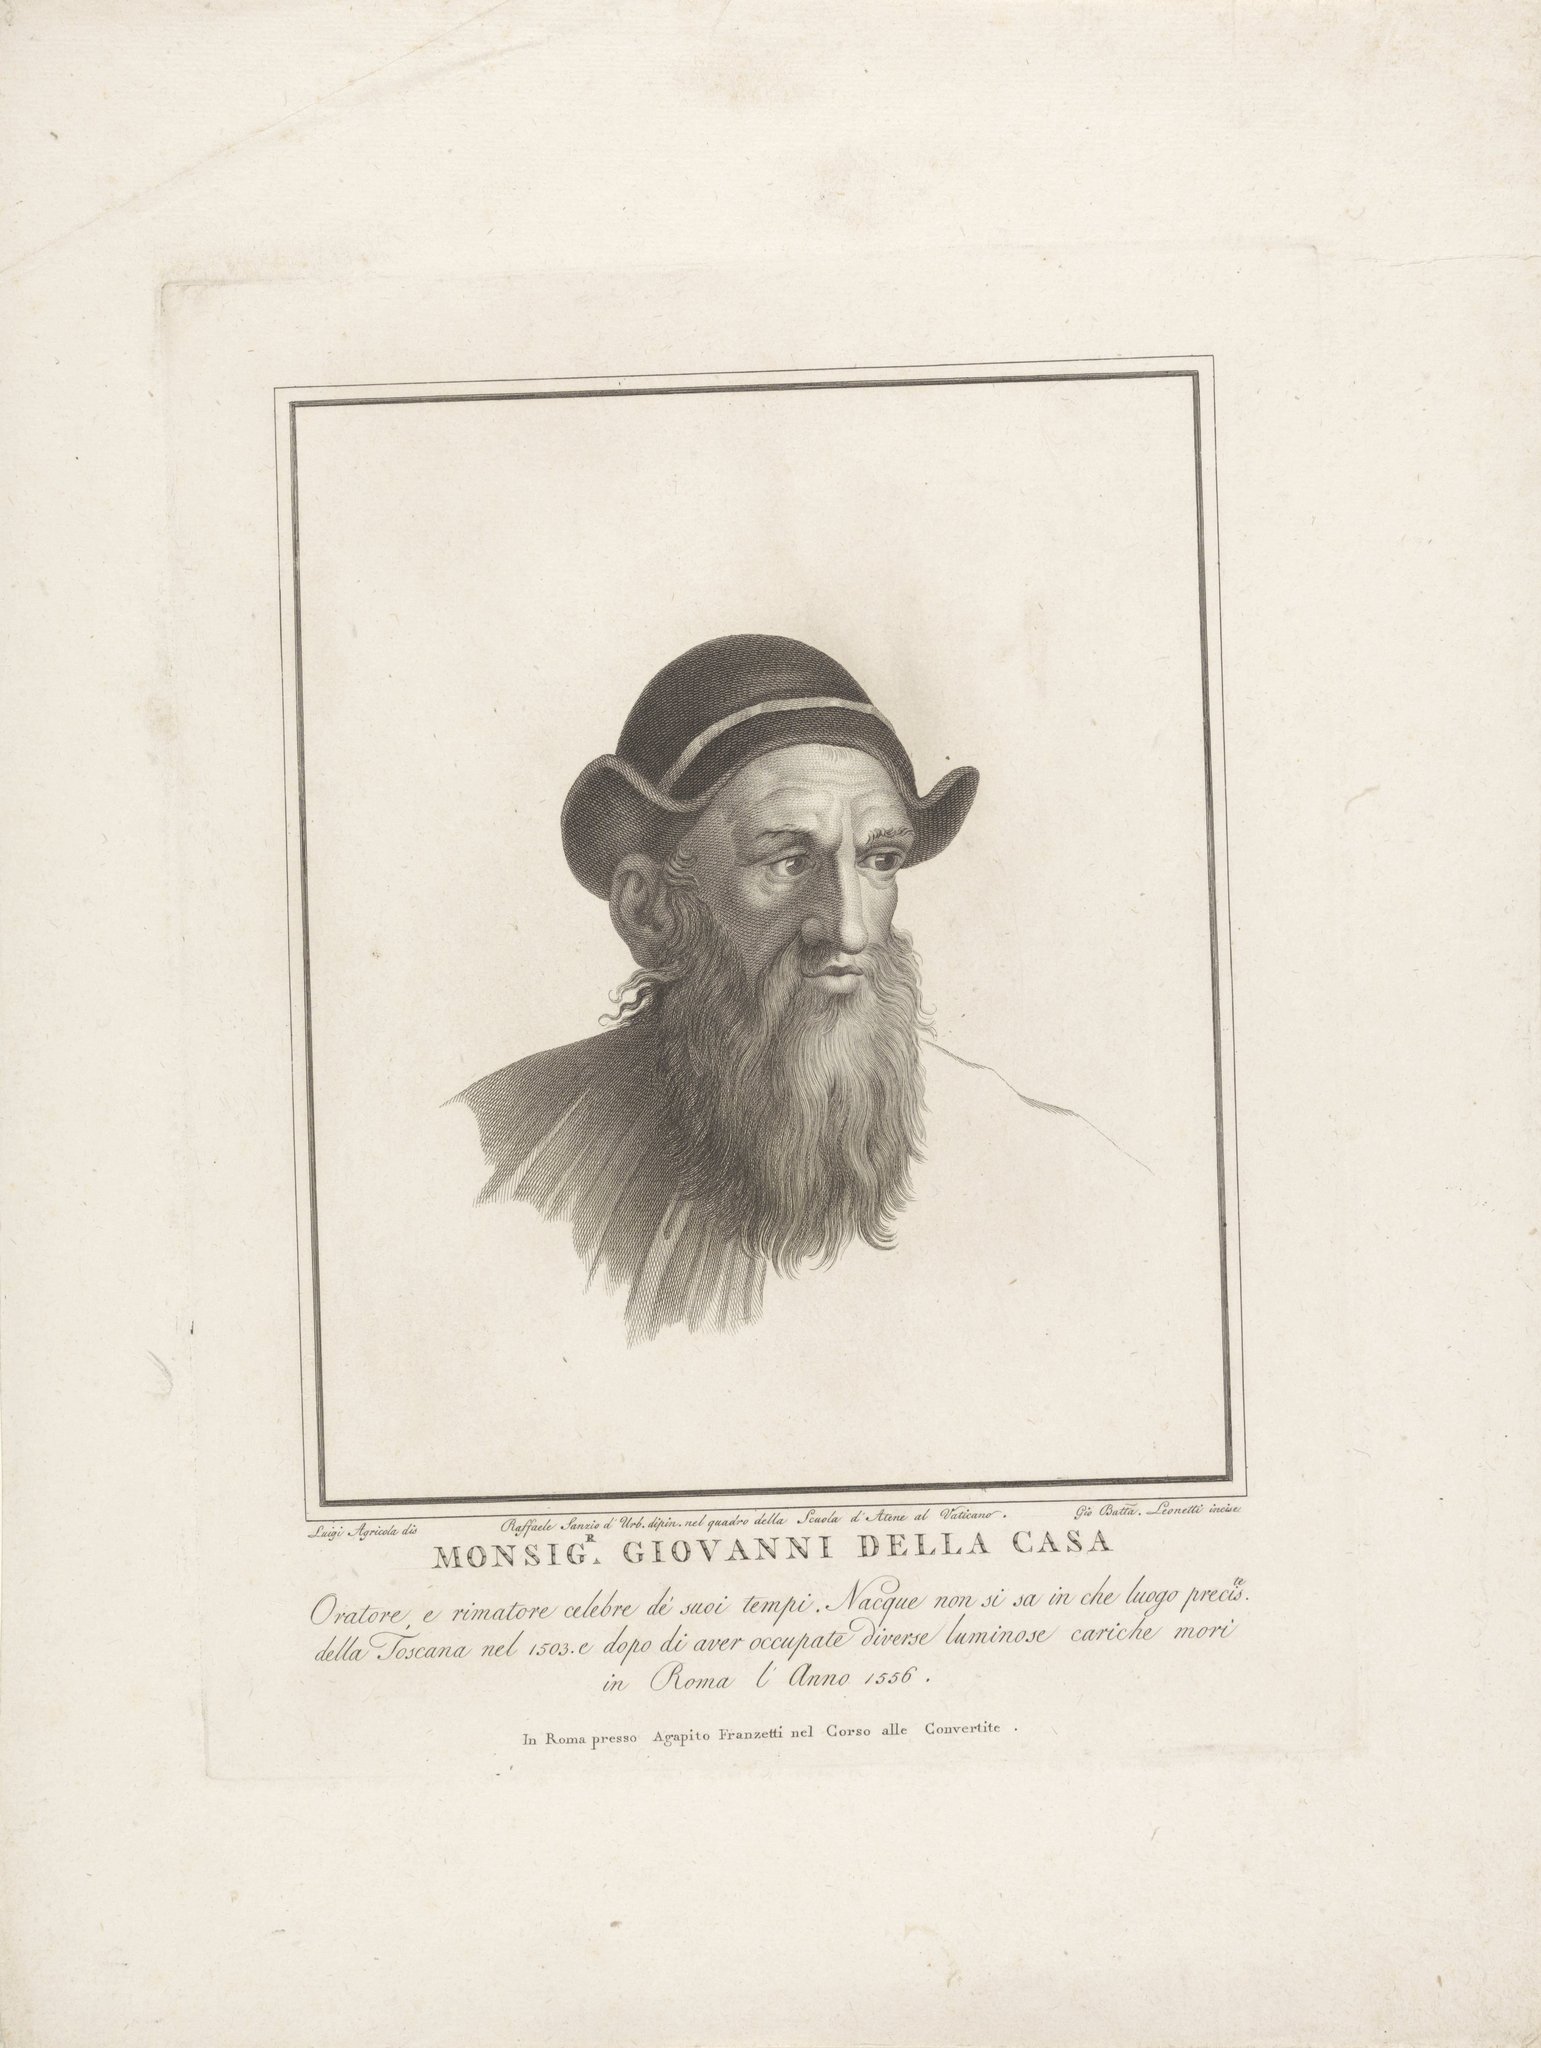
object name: print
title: portret van dichter Giovanni della Casa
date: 1800-1899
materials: paper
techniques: engraving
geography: vatican city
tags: historical persons, portrait of a writer, writer, poet, author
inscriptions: collector's mark: Lugt 2228